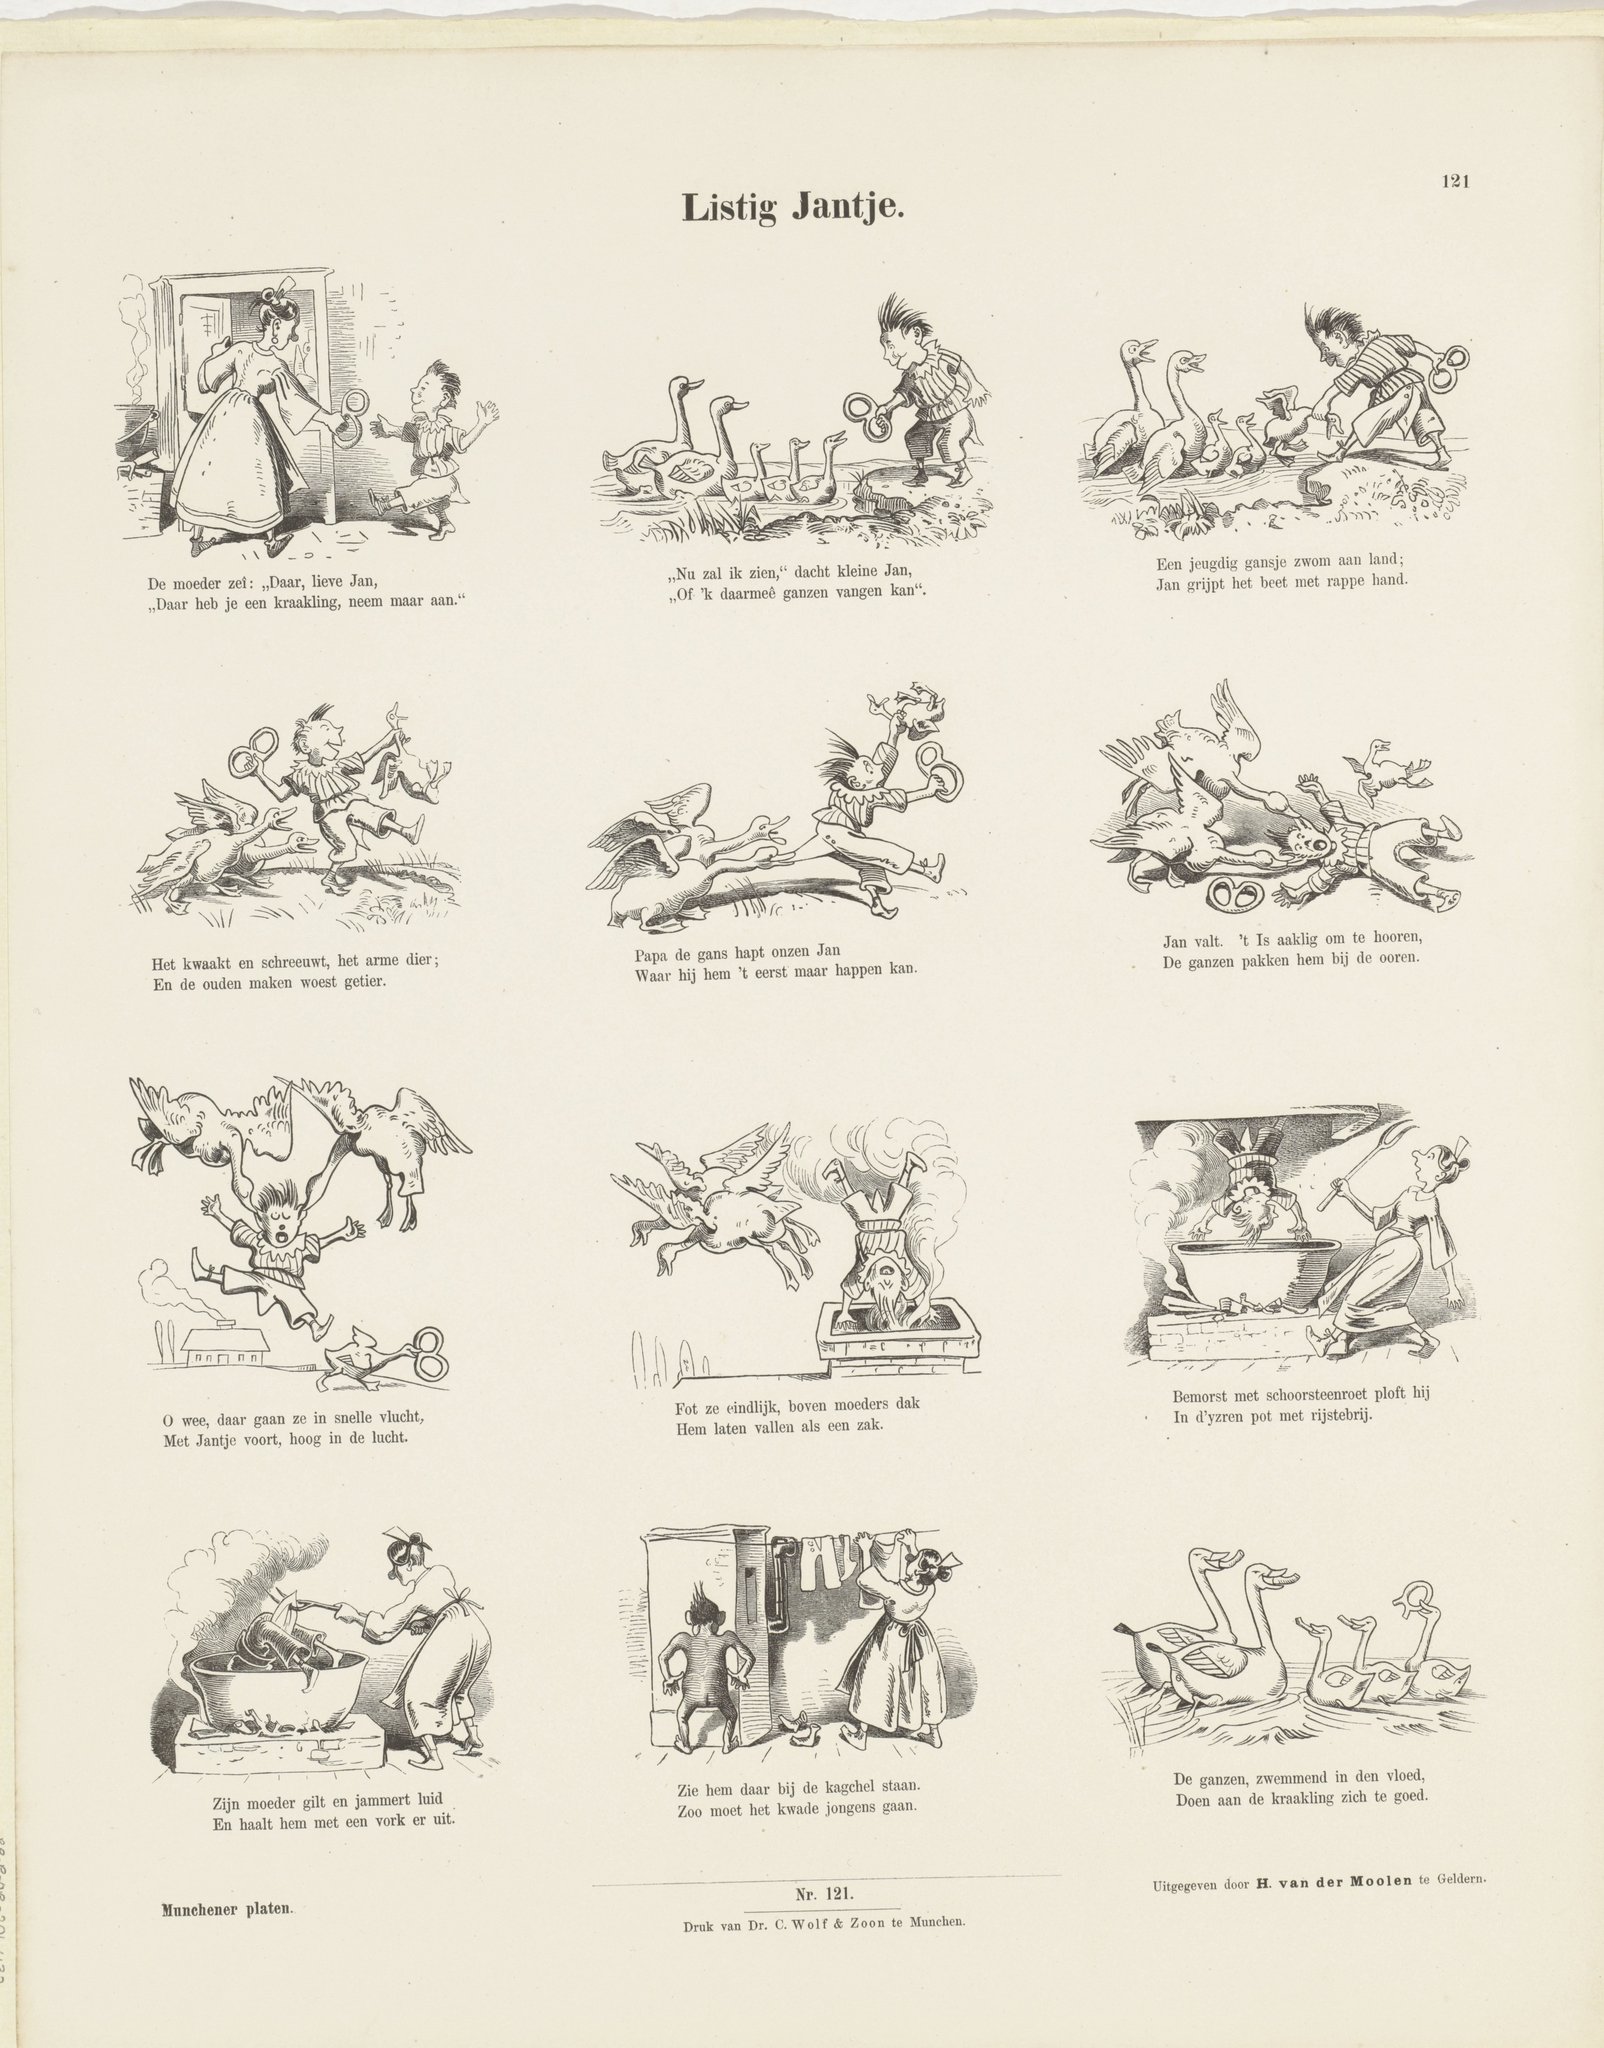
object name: print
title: Munchener platen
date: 1843-1920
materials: paper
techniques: letterpress printing, engraving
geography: germany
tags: correction of naughty children, water-birds: goose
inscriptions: collector's mark: Lugt 2760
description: Blad met 12 voorstellingen over Jantje die de ganzen plaagt. De ganzen nemen hem als wraak mee op een luchtreis, waarna hij bij zijn moeder in een ketel met rijstebrij belandt. Onder elke afbeelding een tweeregelig vers. Genummerd midden onder: Nro. 121. Genummerd rechtsboven: 121.